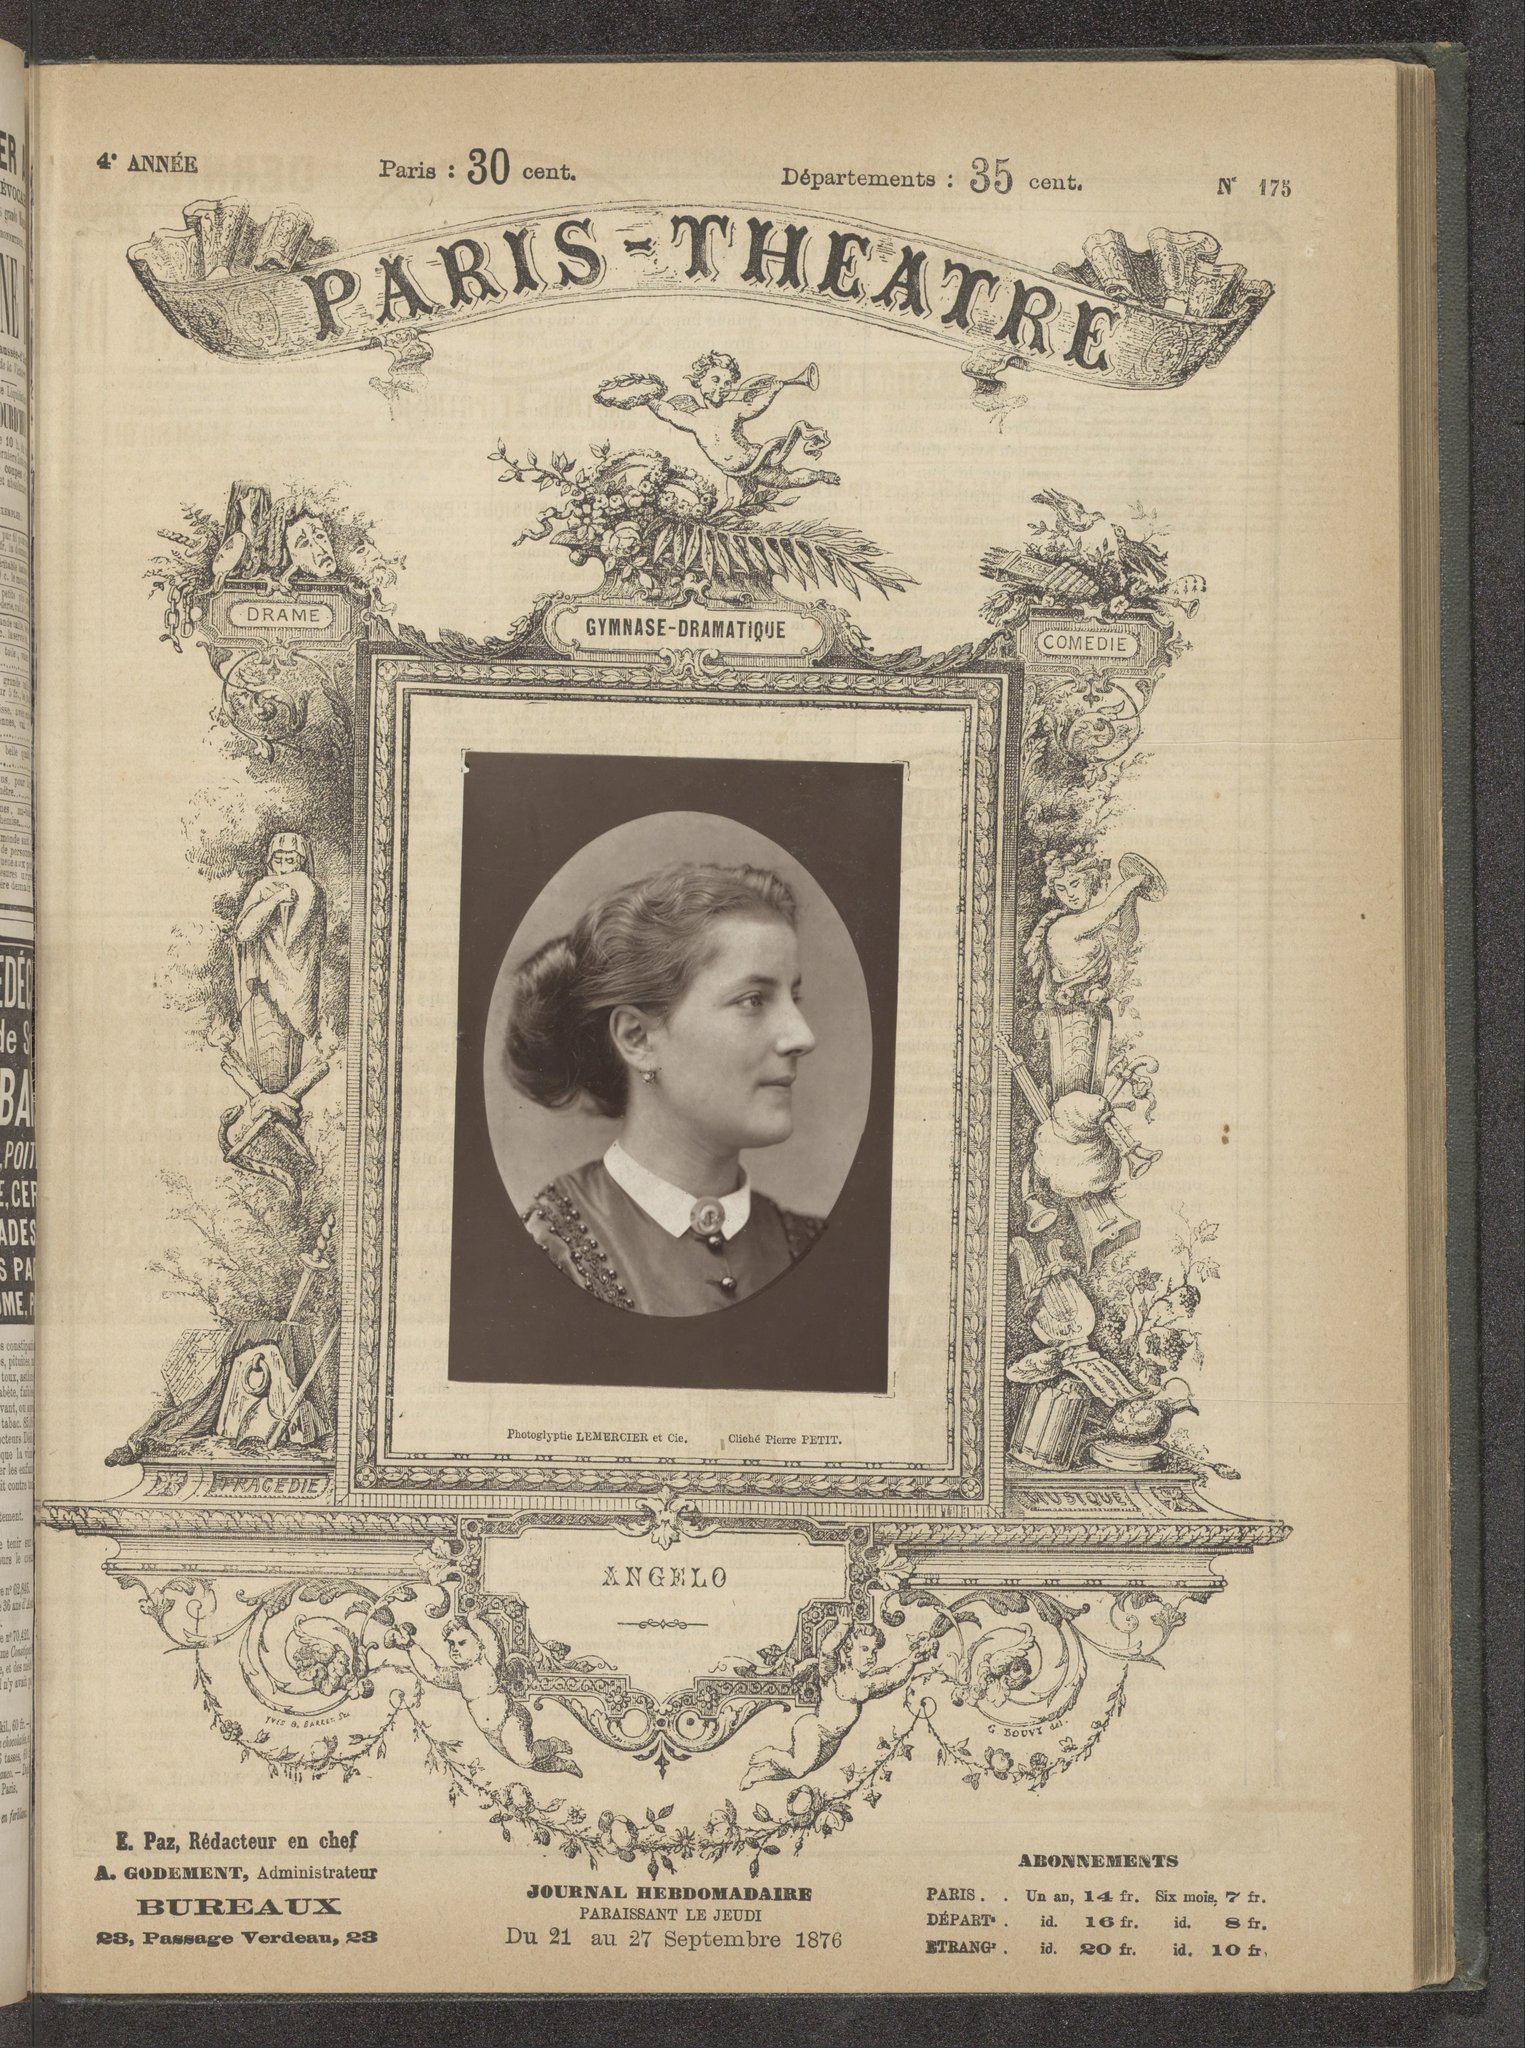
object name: page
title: Portret van Marie-Anne Angelo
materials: paper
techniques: woodburytype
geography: france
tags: portrait of actor, actress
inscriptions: inscription: ‘Journal hebdomadaire paraissant le jeudi Du 21 au 27 Septembre 1876’, number: ‘No 175’